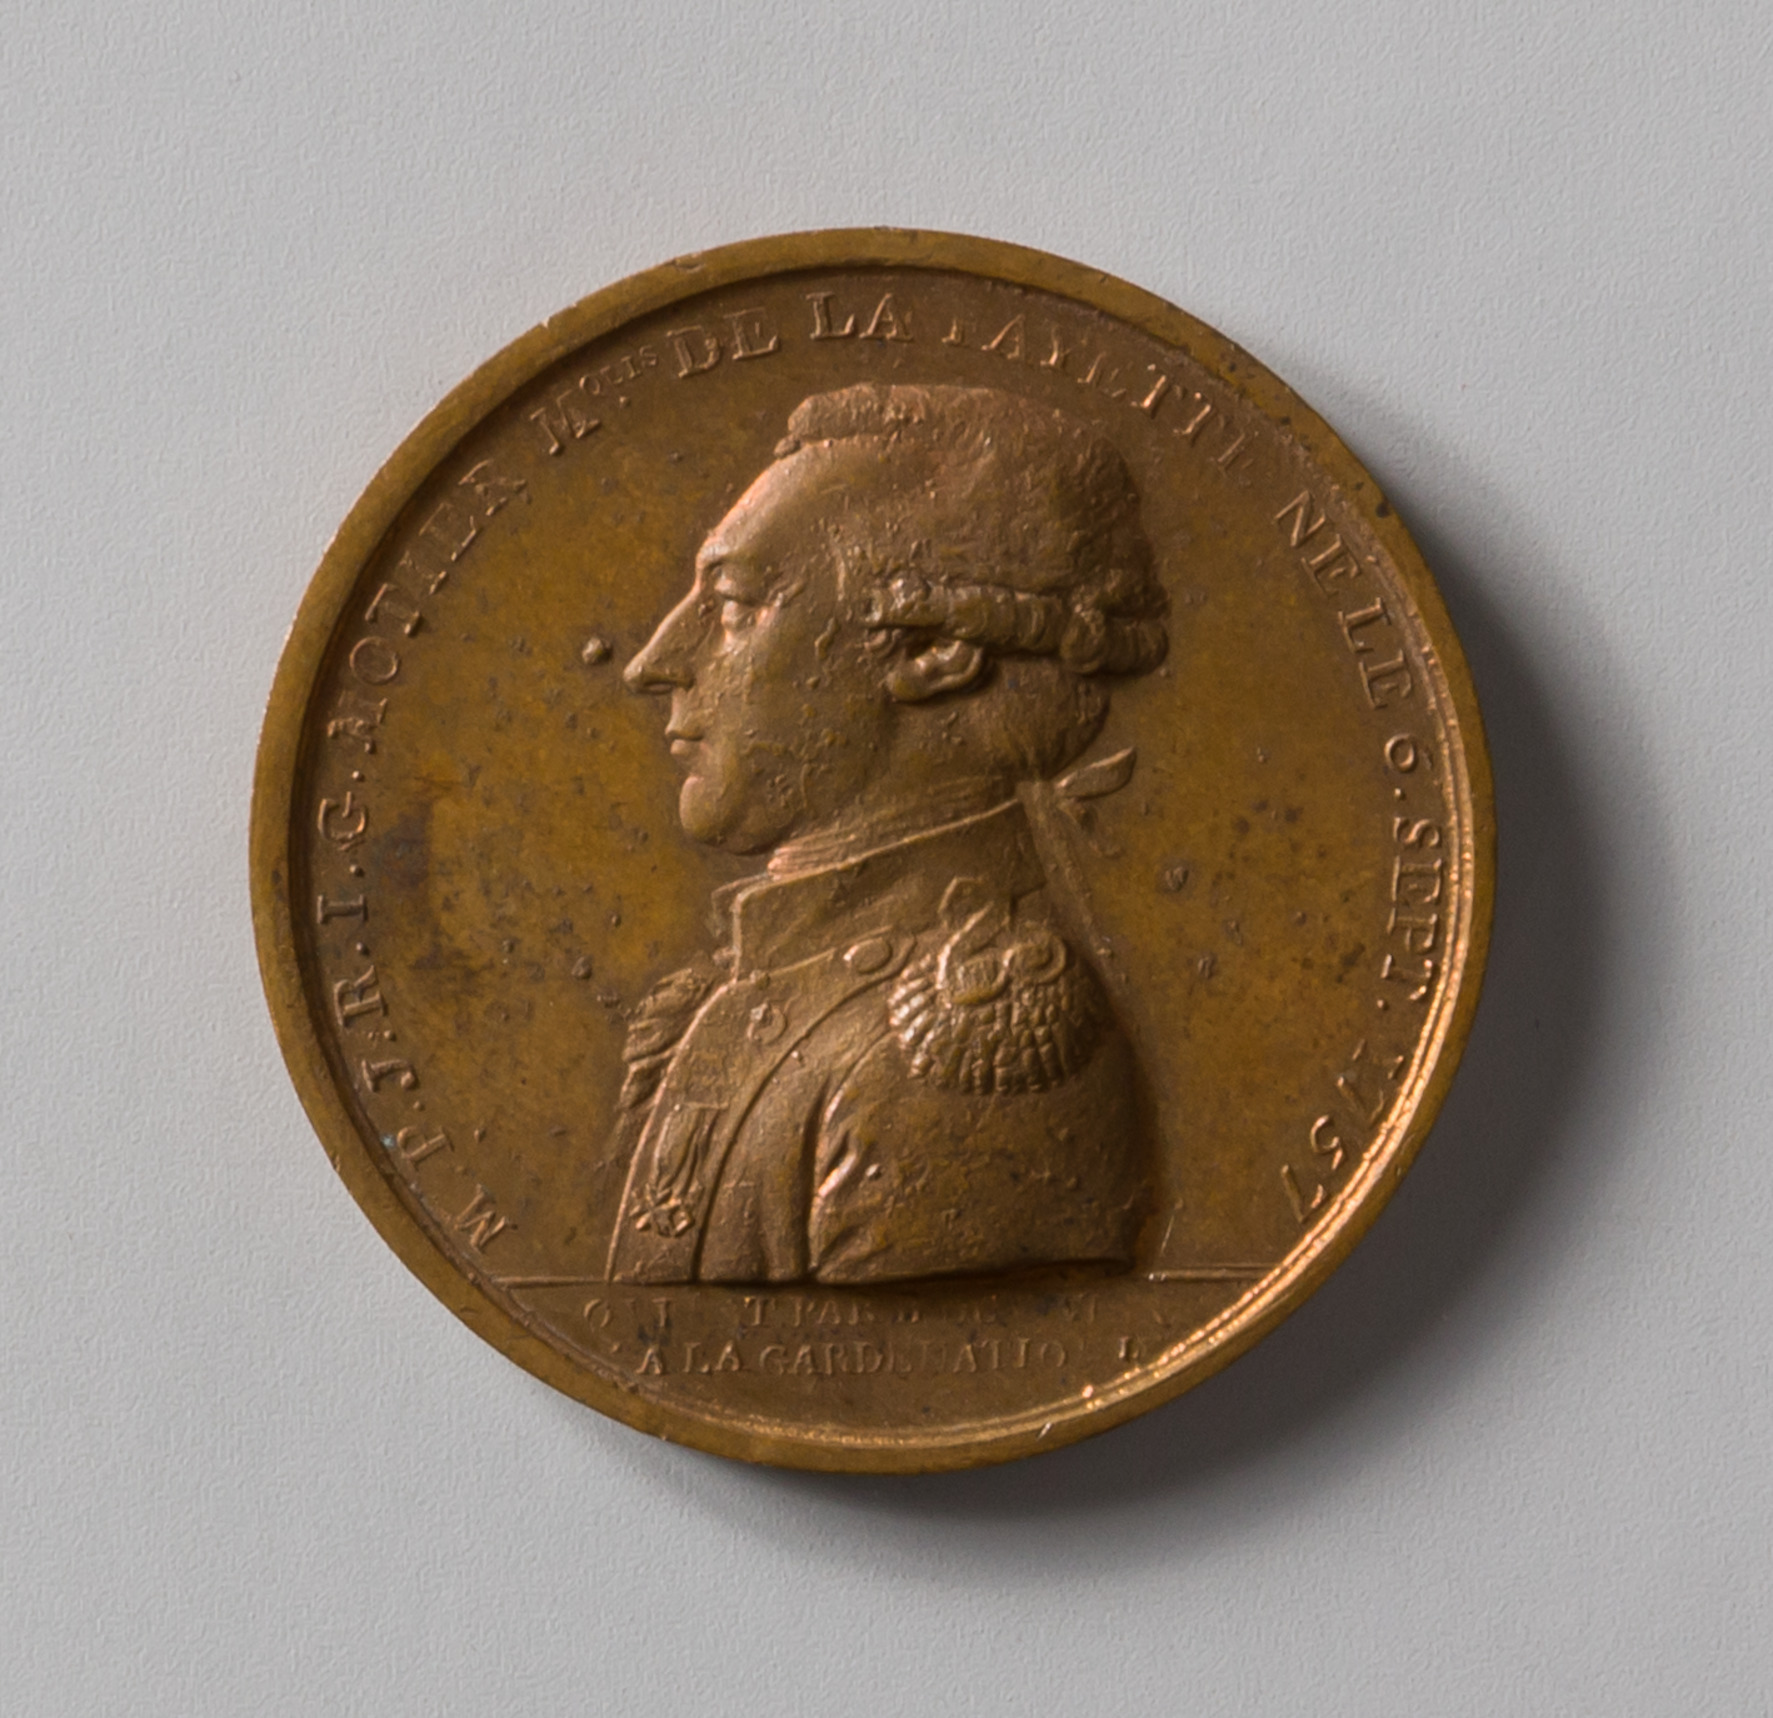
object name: medal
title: Medal of the Marquis de Lafayette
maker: pierre simon benj. duvivier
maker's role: maker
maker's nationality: french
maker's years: 1730-1819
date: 1789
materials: gilt bronze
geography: france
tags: men,profiles,marquis de lafayette